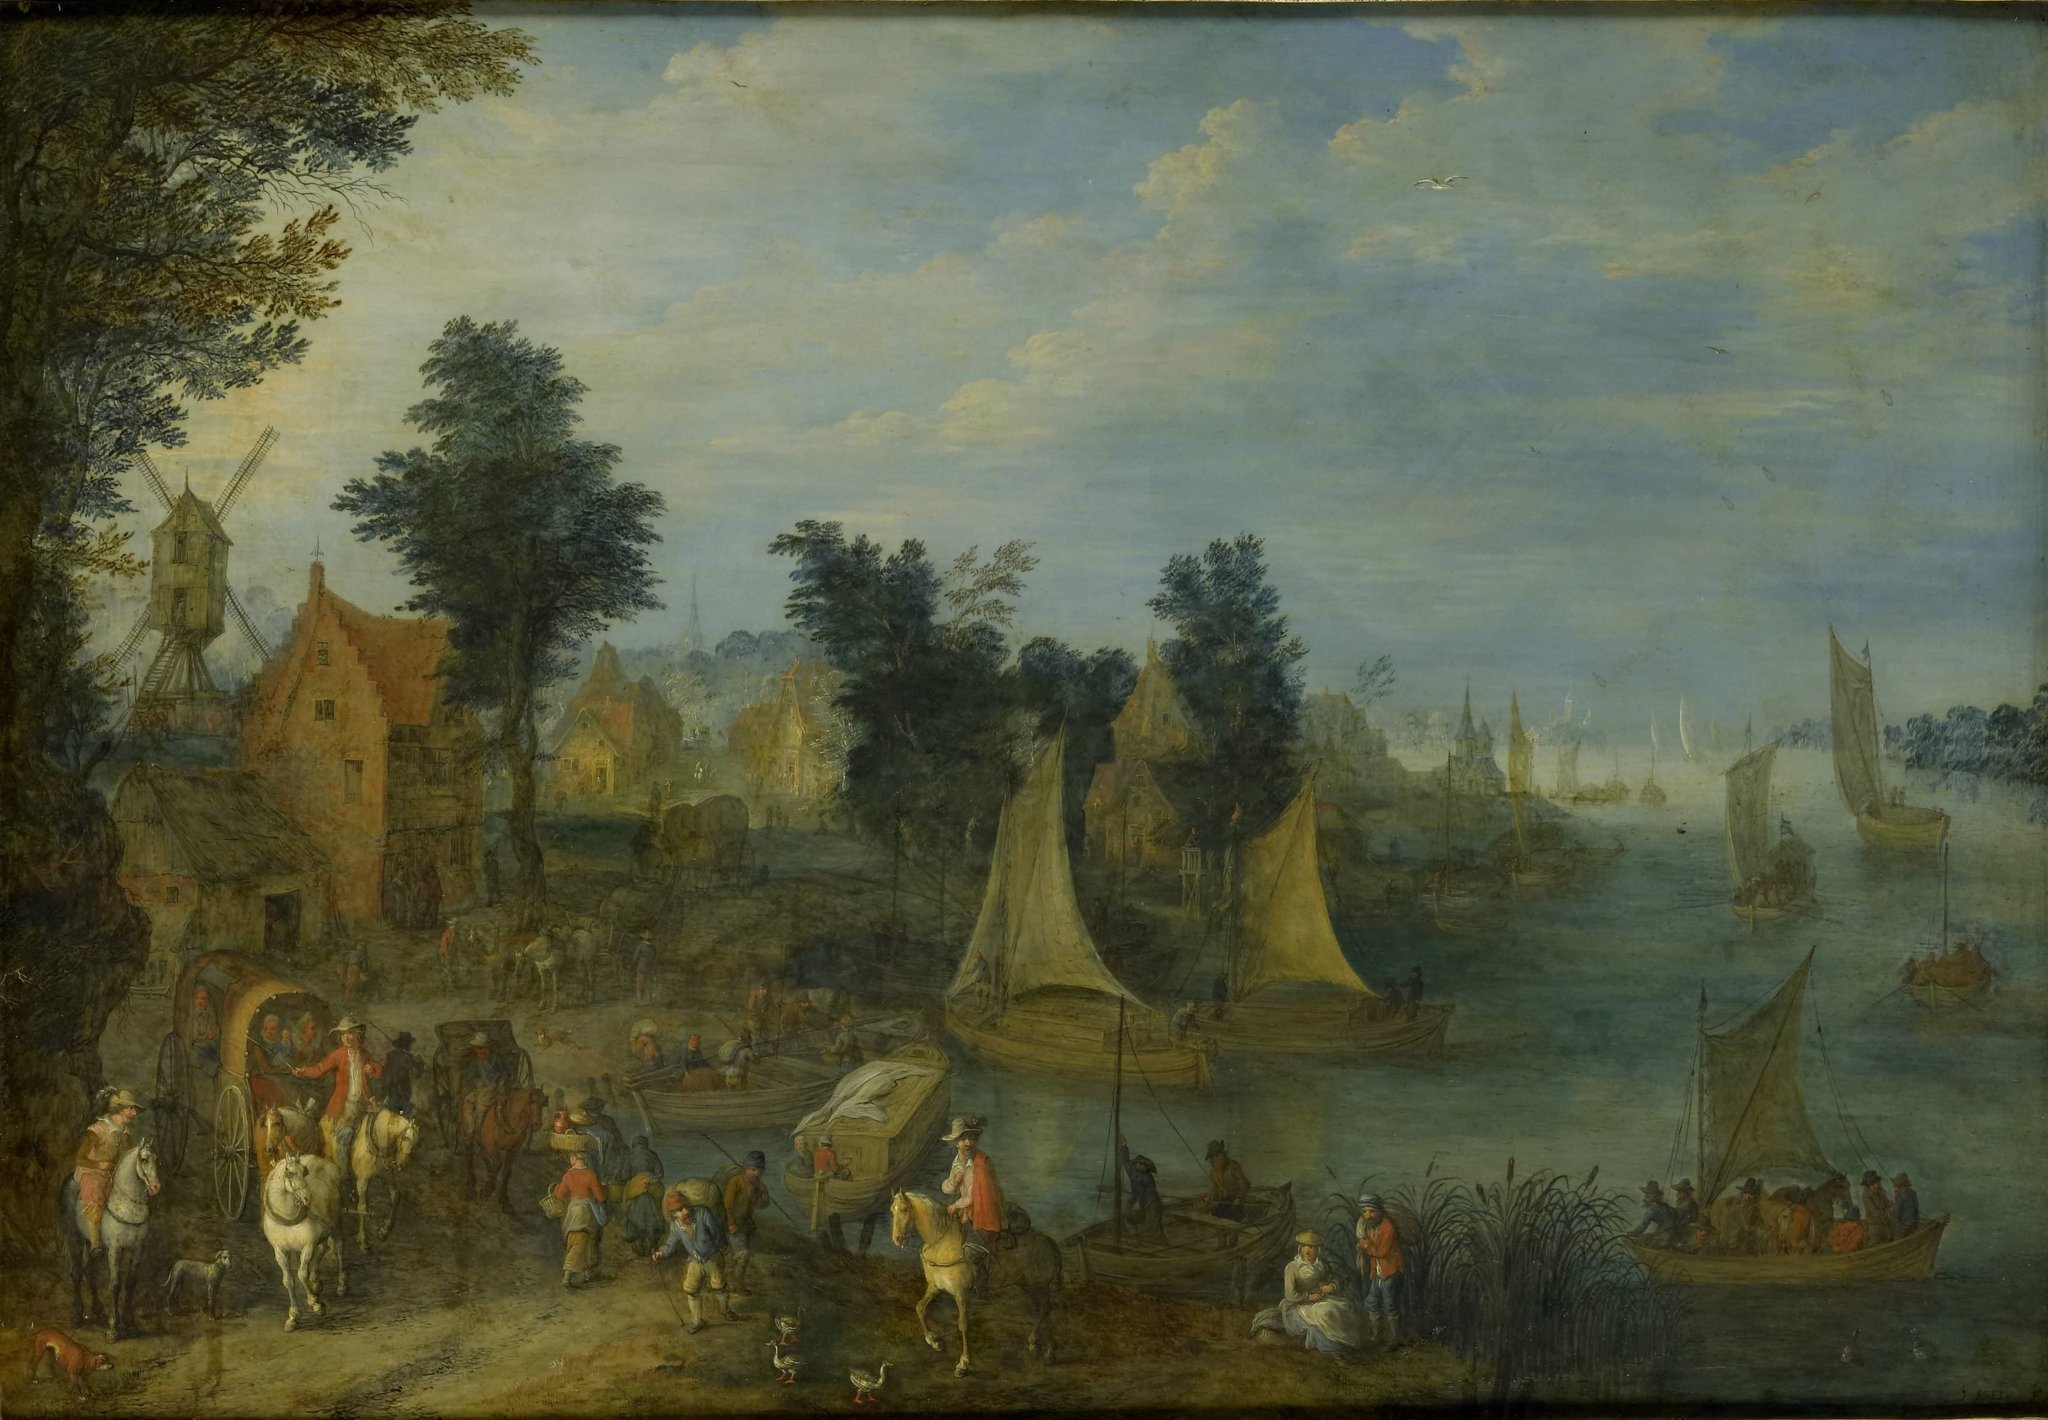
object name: painting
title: Village on the Bank of a River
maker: joseph van bredael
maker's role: painter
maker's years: 1688-1739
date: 1723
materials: oil, panel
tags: prospect of village, silhouette of village, canals, waters (in village)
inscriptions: signature and date: ‘J. BREDA F. 1723’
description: Dorp aan de oever van een rivier. Gezicht op een dorp gelegen aan een rivier. Links allerlei figuren, een koets, ruiters en een windmolen. Rechts bootjes op het water.